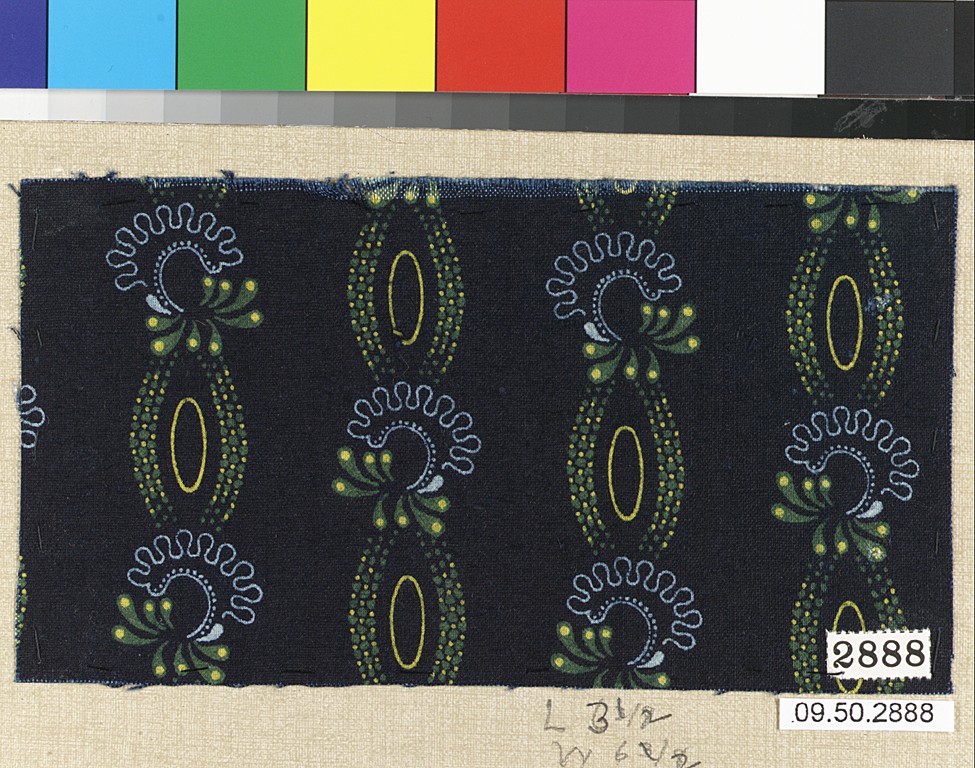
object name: piece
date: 1801-1900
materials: cotton